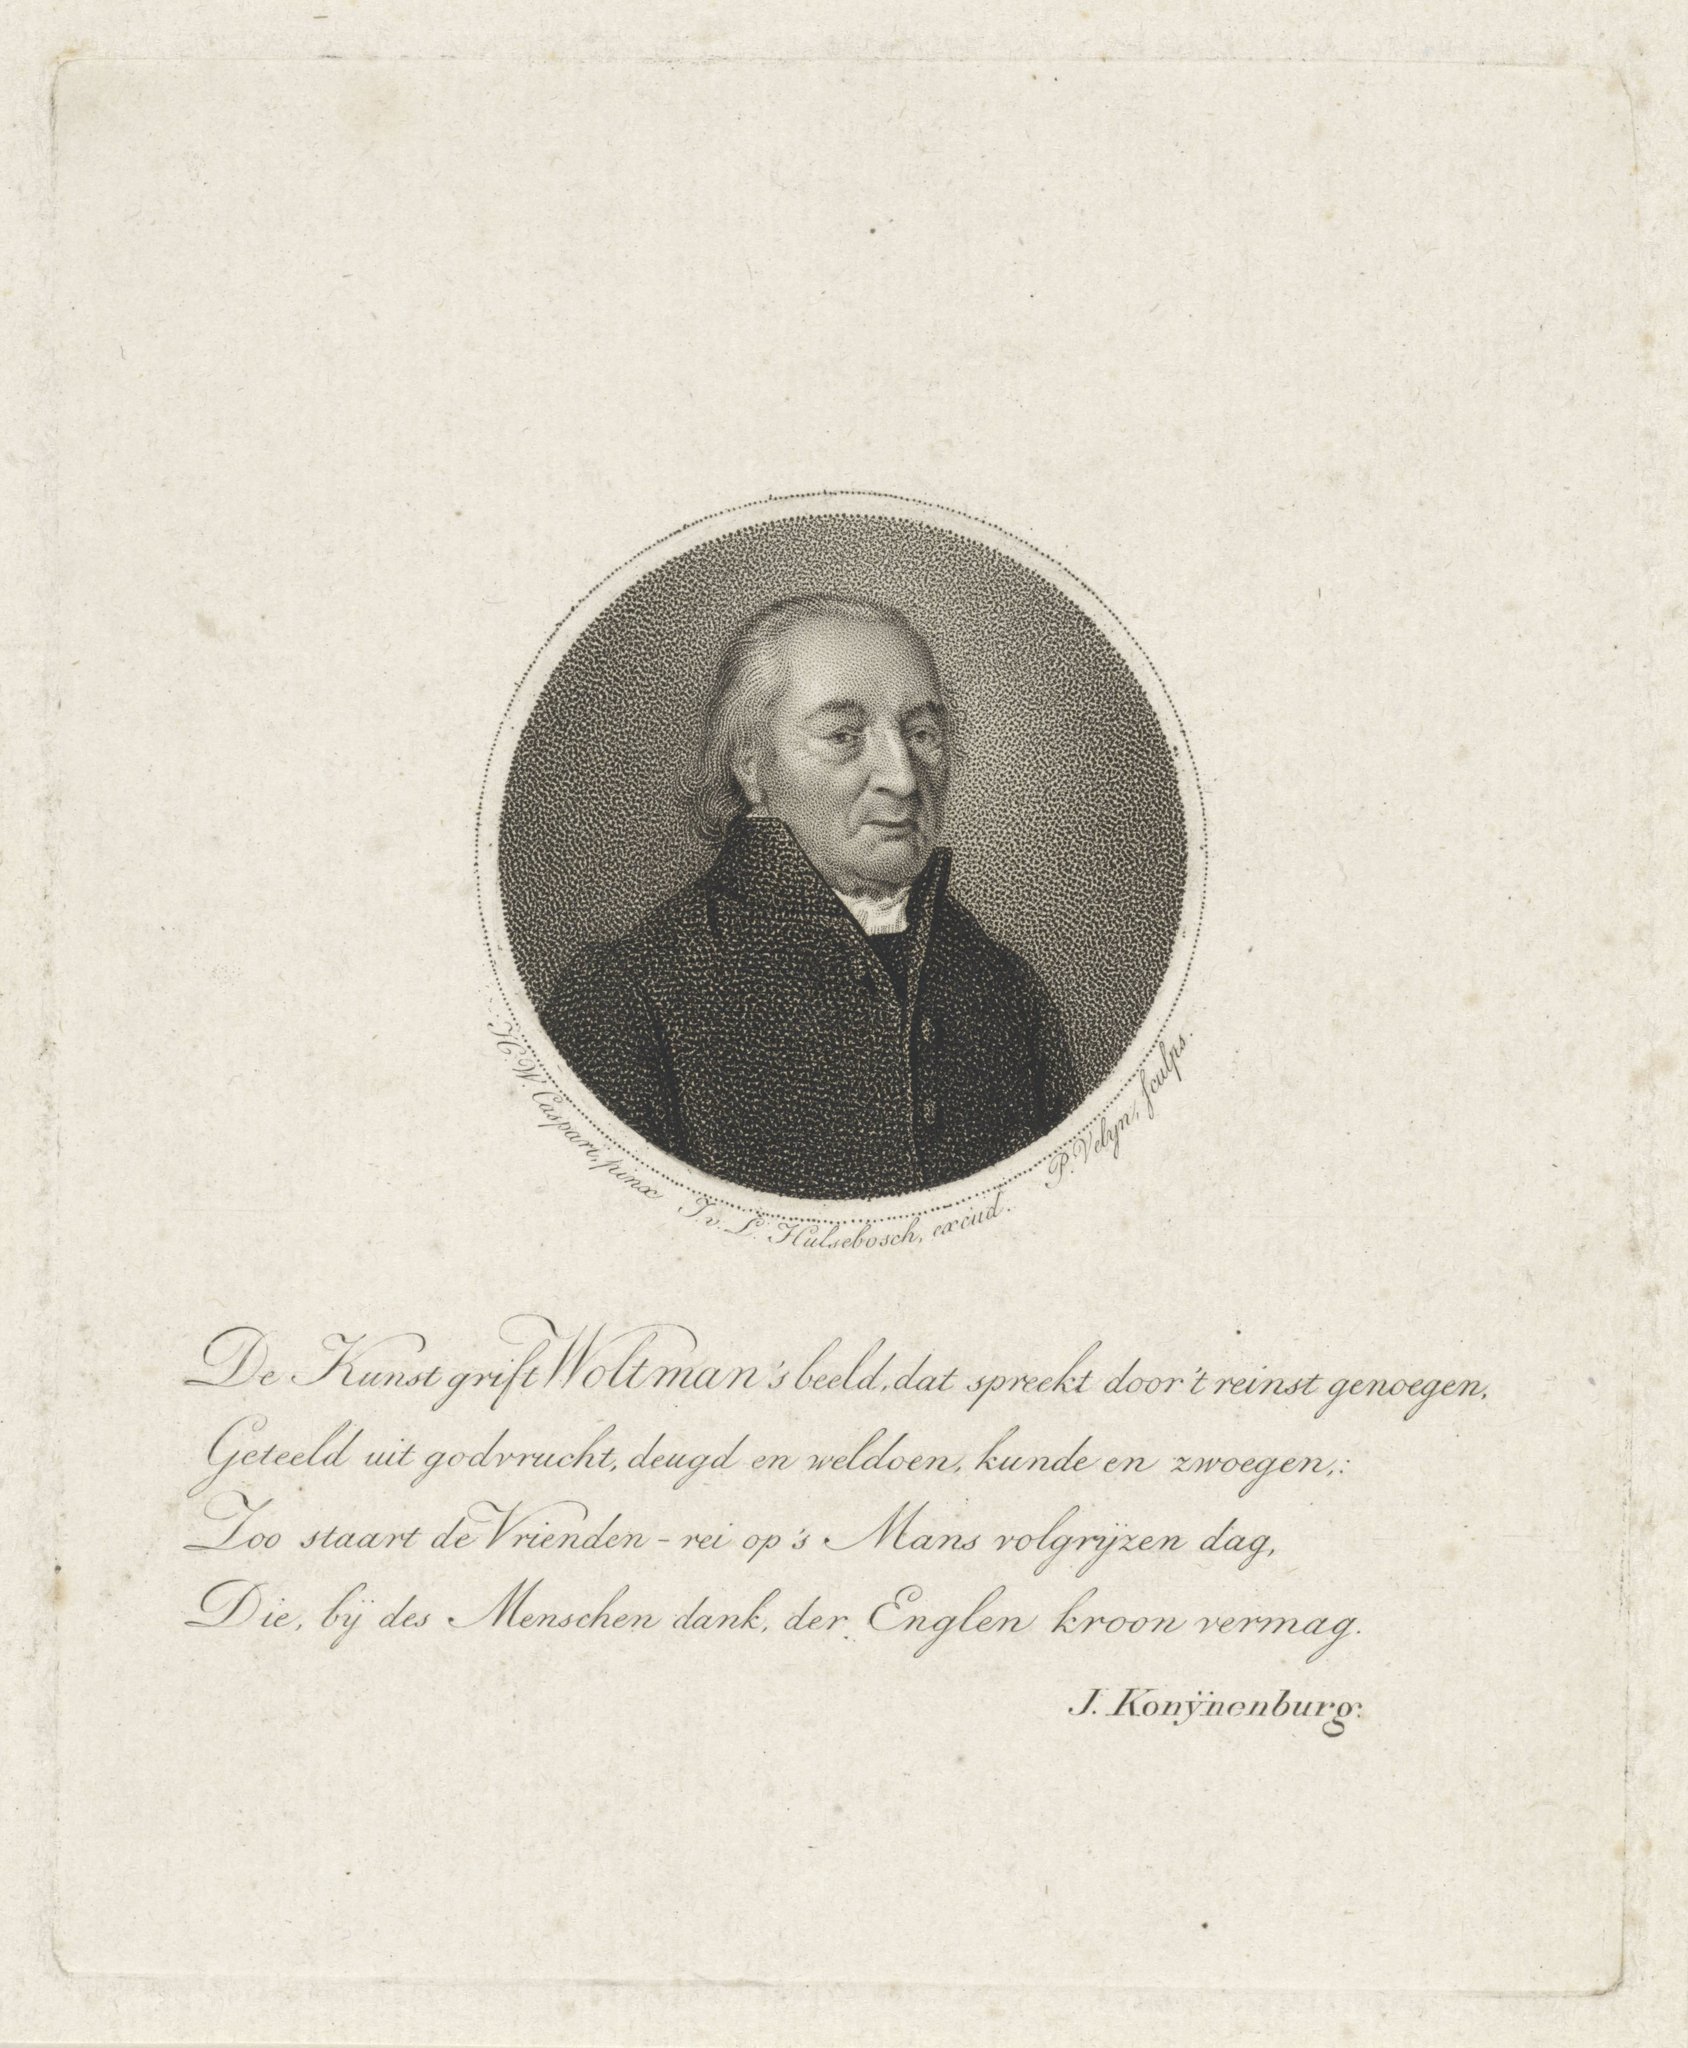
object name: print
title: Portret van Johannes Matthias Woltman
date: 1787-1836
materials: paper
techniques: stippled etching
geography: amsterdam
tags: purmerend, apotheker, johannes matthias woltman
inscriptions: collector's mark: Lugt 2228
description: Portret van Johannes Matthias Woltman, apotheker te Purmerend